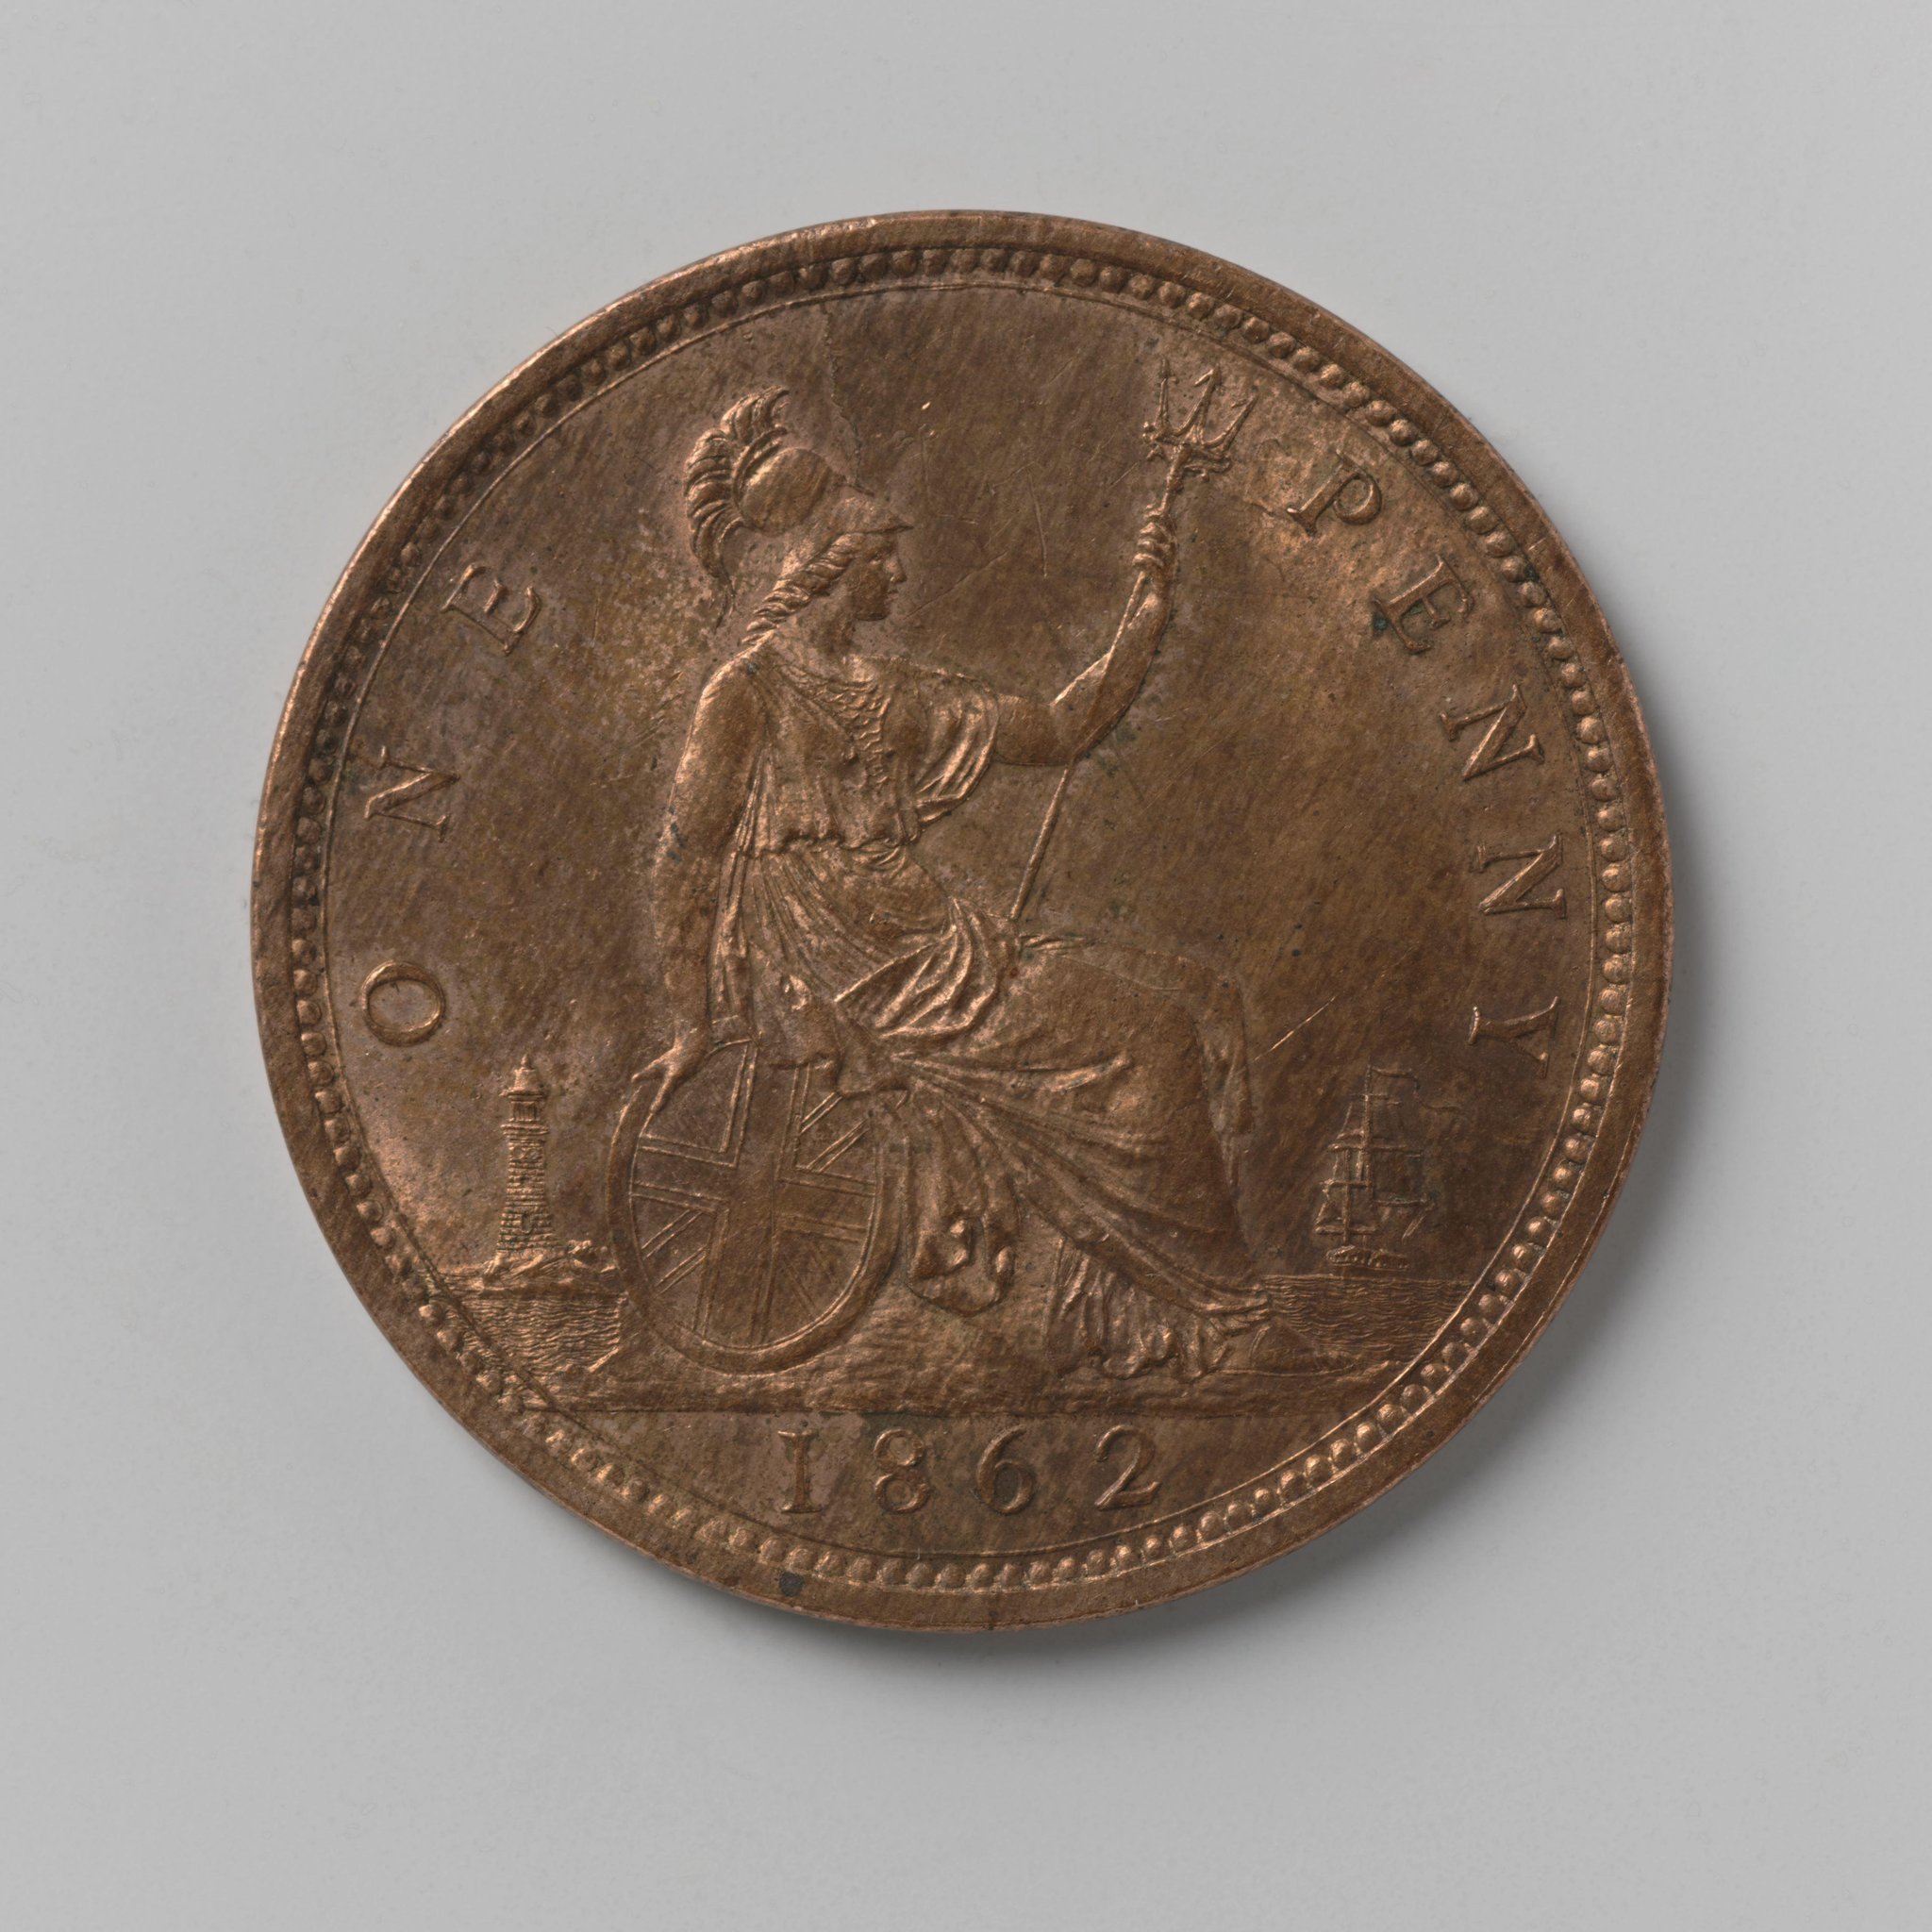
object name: coin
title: Engeland, Victoria, penny, 1862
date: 1862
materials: bronze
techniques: striking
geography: london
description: Bronzen munt. Voorzijde: hoofd van de koningin met lauwerkrans naar links [bun head]. Keerzijde: tegen wapenschild gezeten Brittannia met drietand, naar rechts. Links van haar vuurtoren, rechts schip. In afsnede jaartal. Waarde-aanduiding als omschrift. Gladde rand.